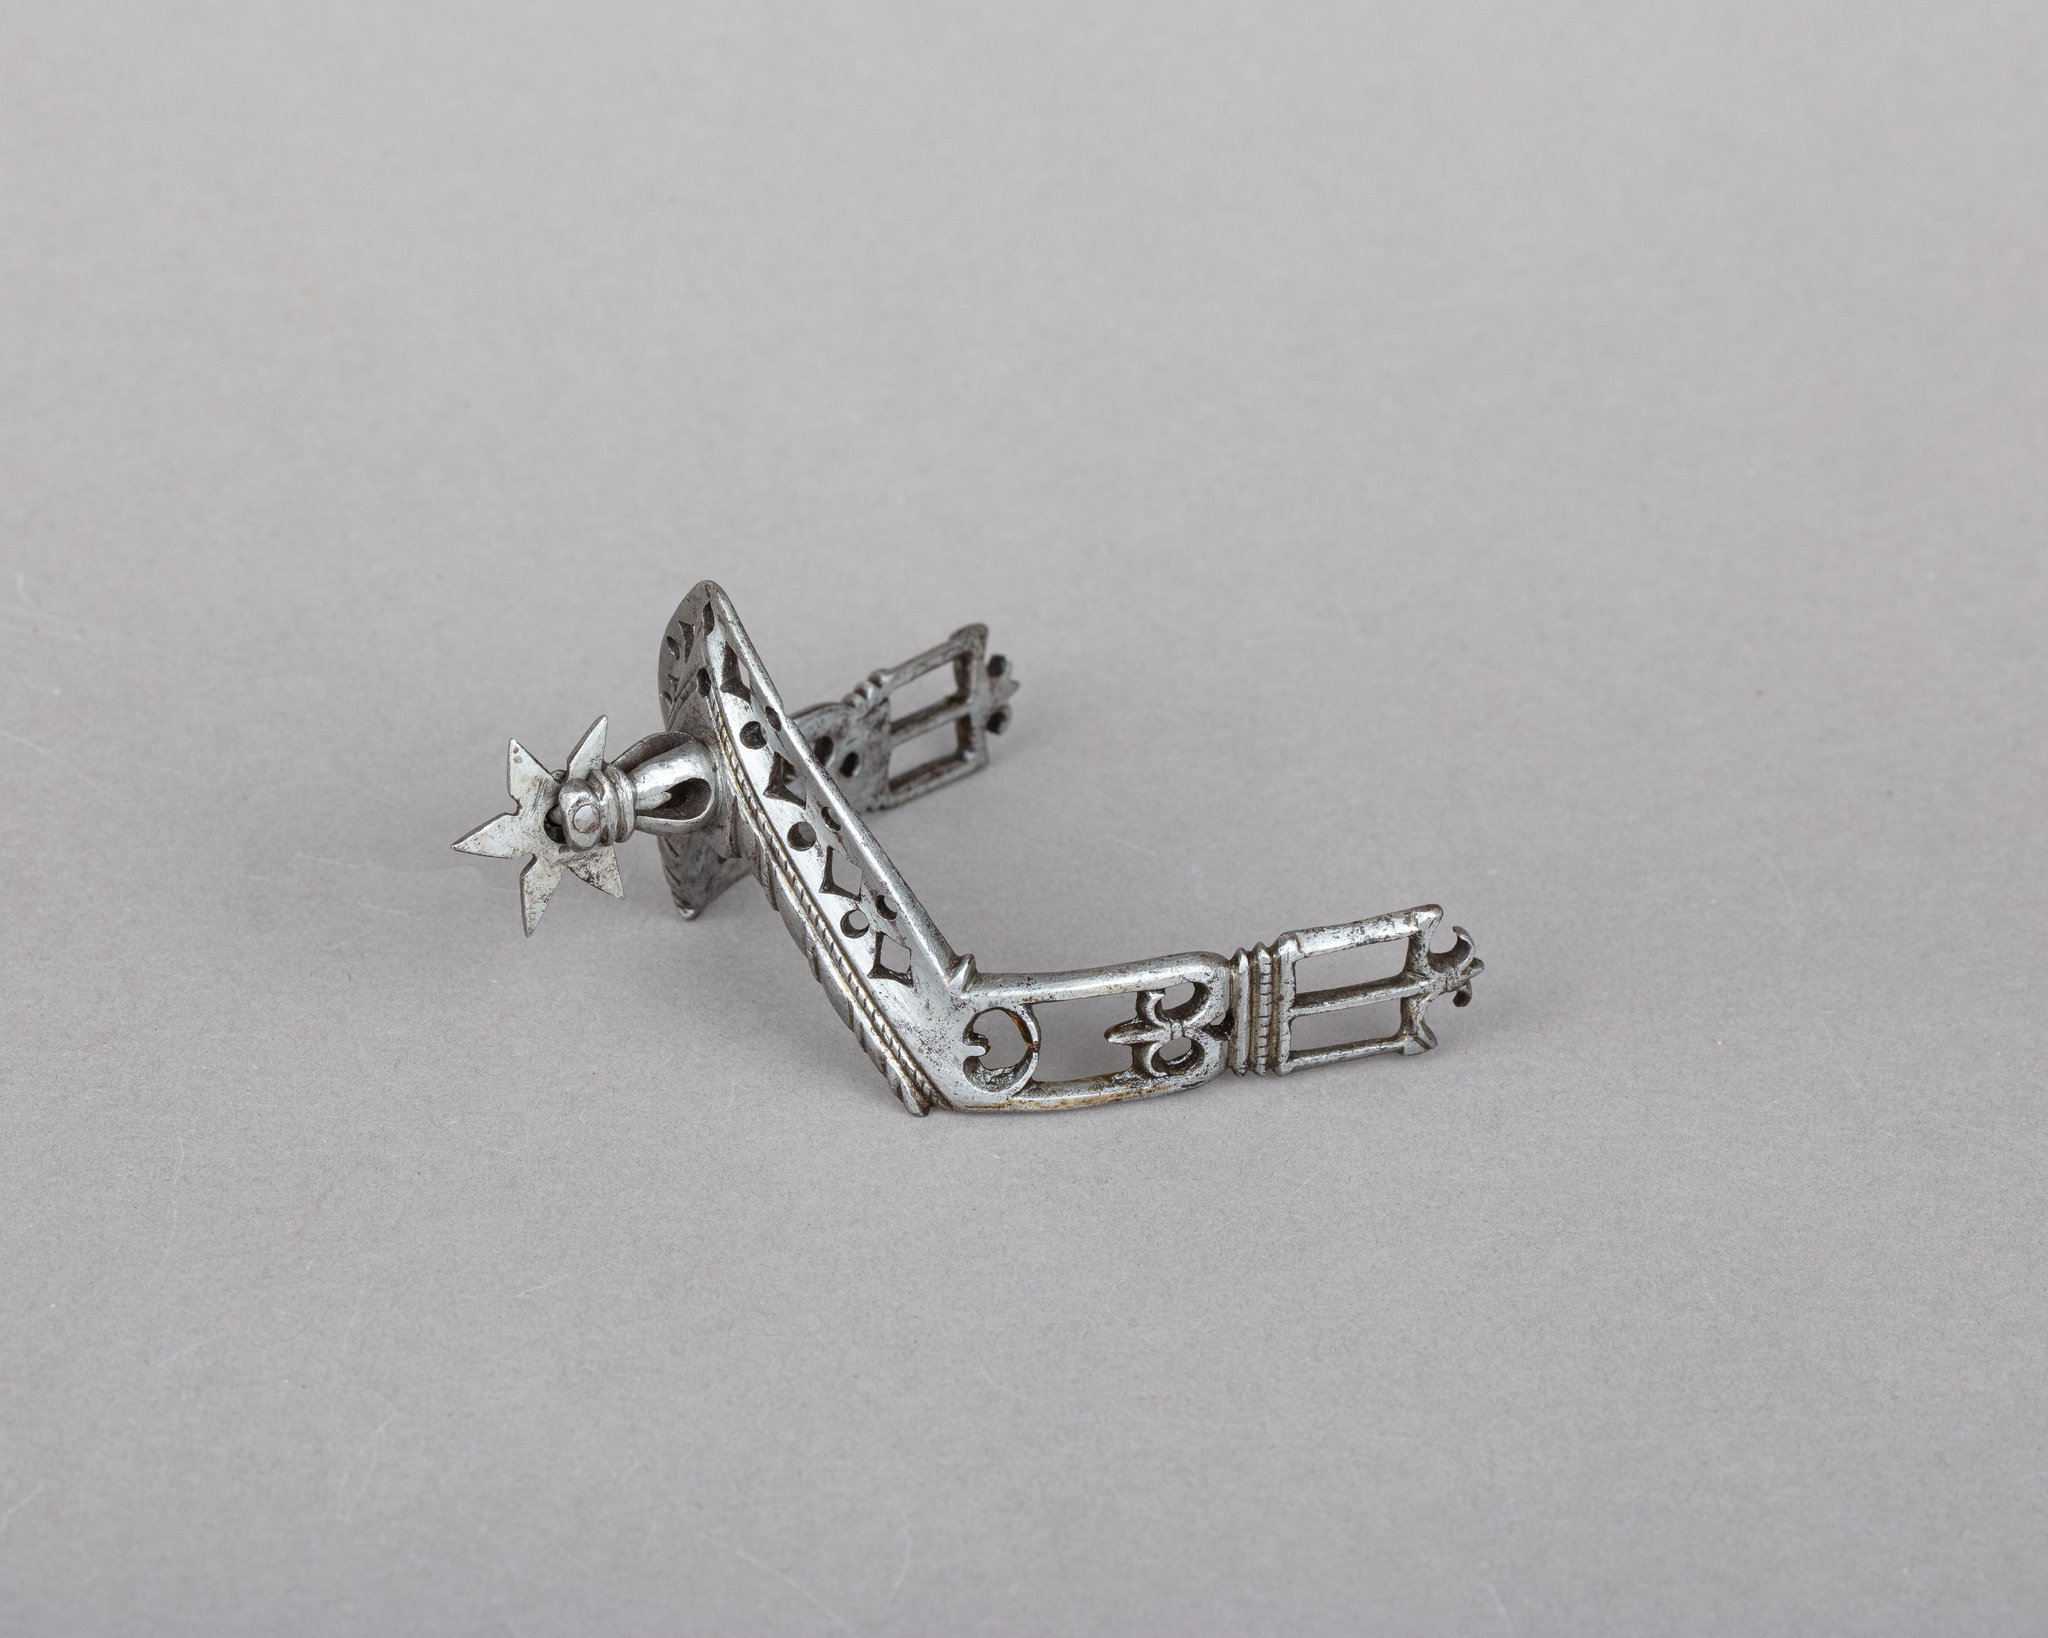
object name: spur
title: Rowel Spur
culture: german or spanish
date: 1601-1633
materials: metal alloy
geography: spain